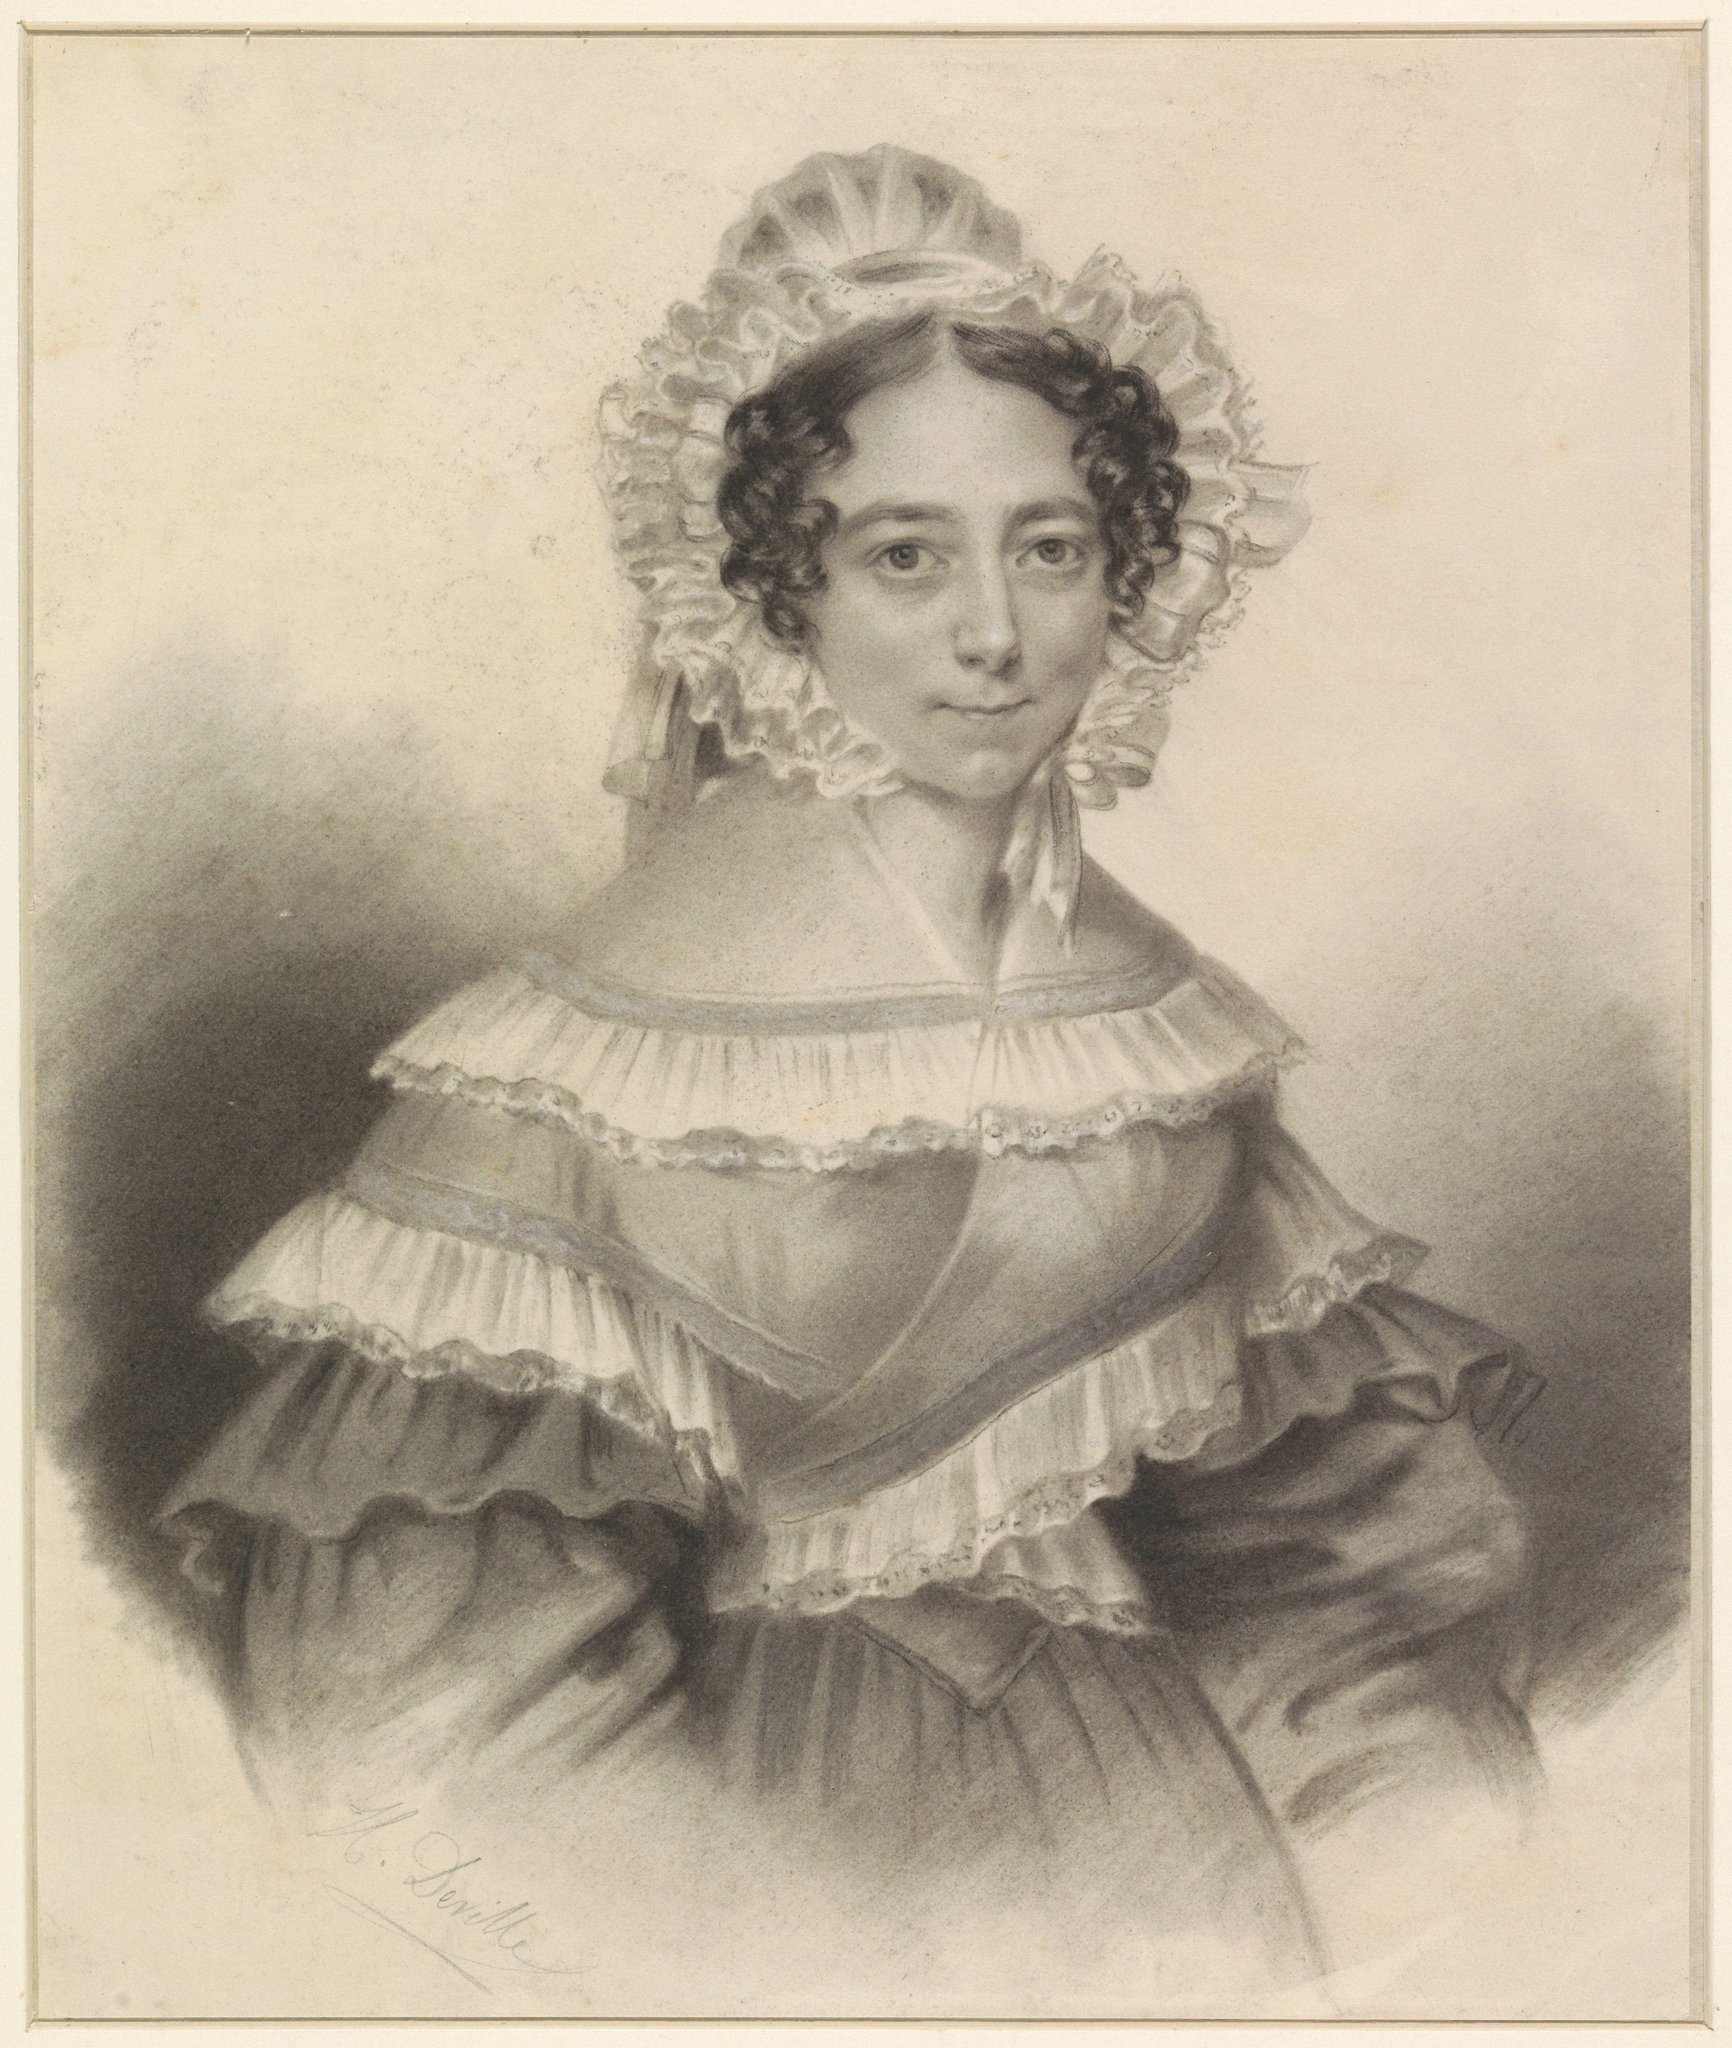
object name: drawing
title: Portret van een dame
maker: h. deville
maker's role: draughtsman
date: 1813-1857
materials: chalk, charcoal, paper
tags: anonymous historical person portrayed alone